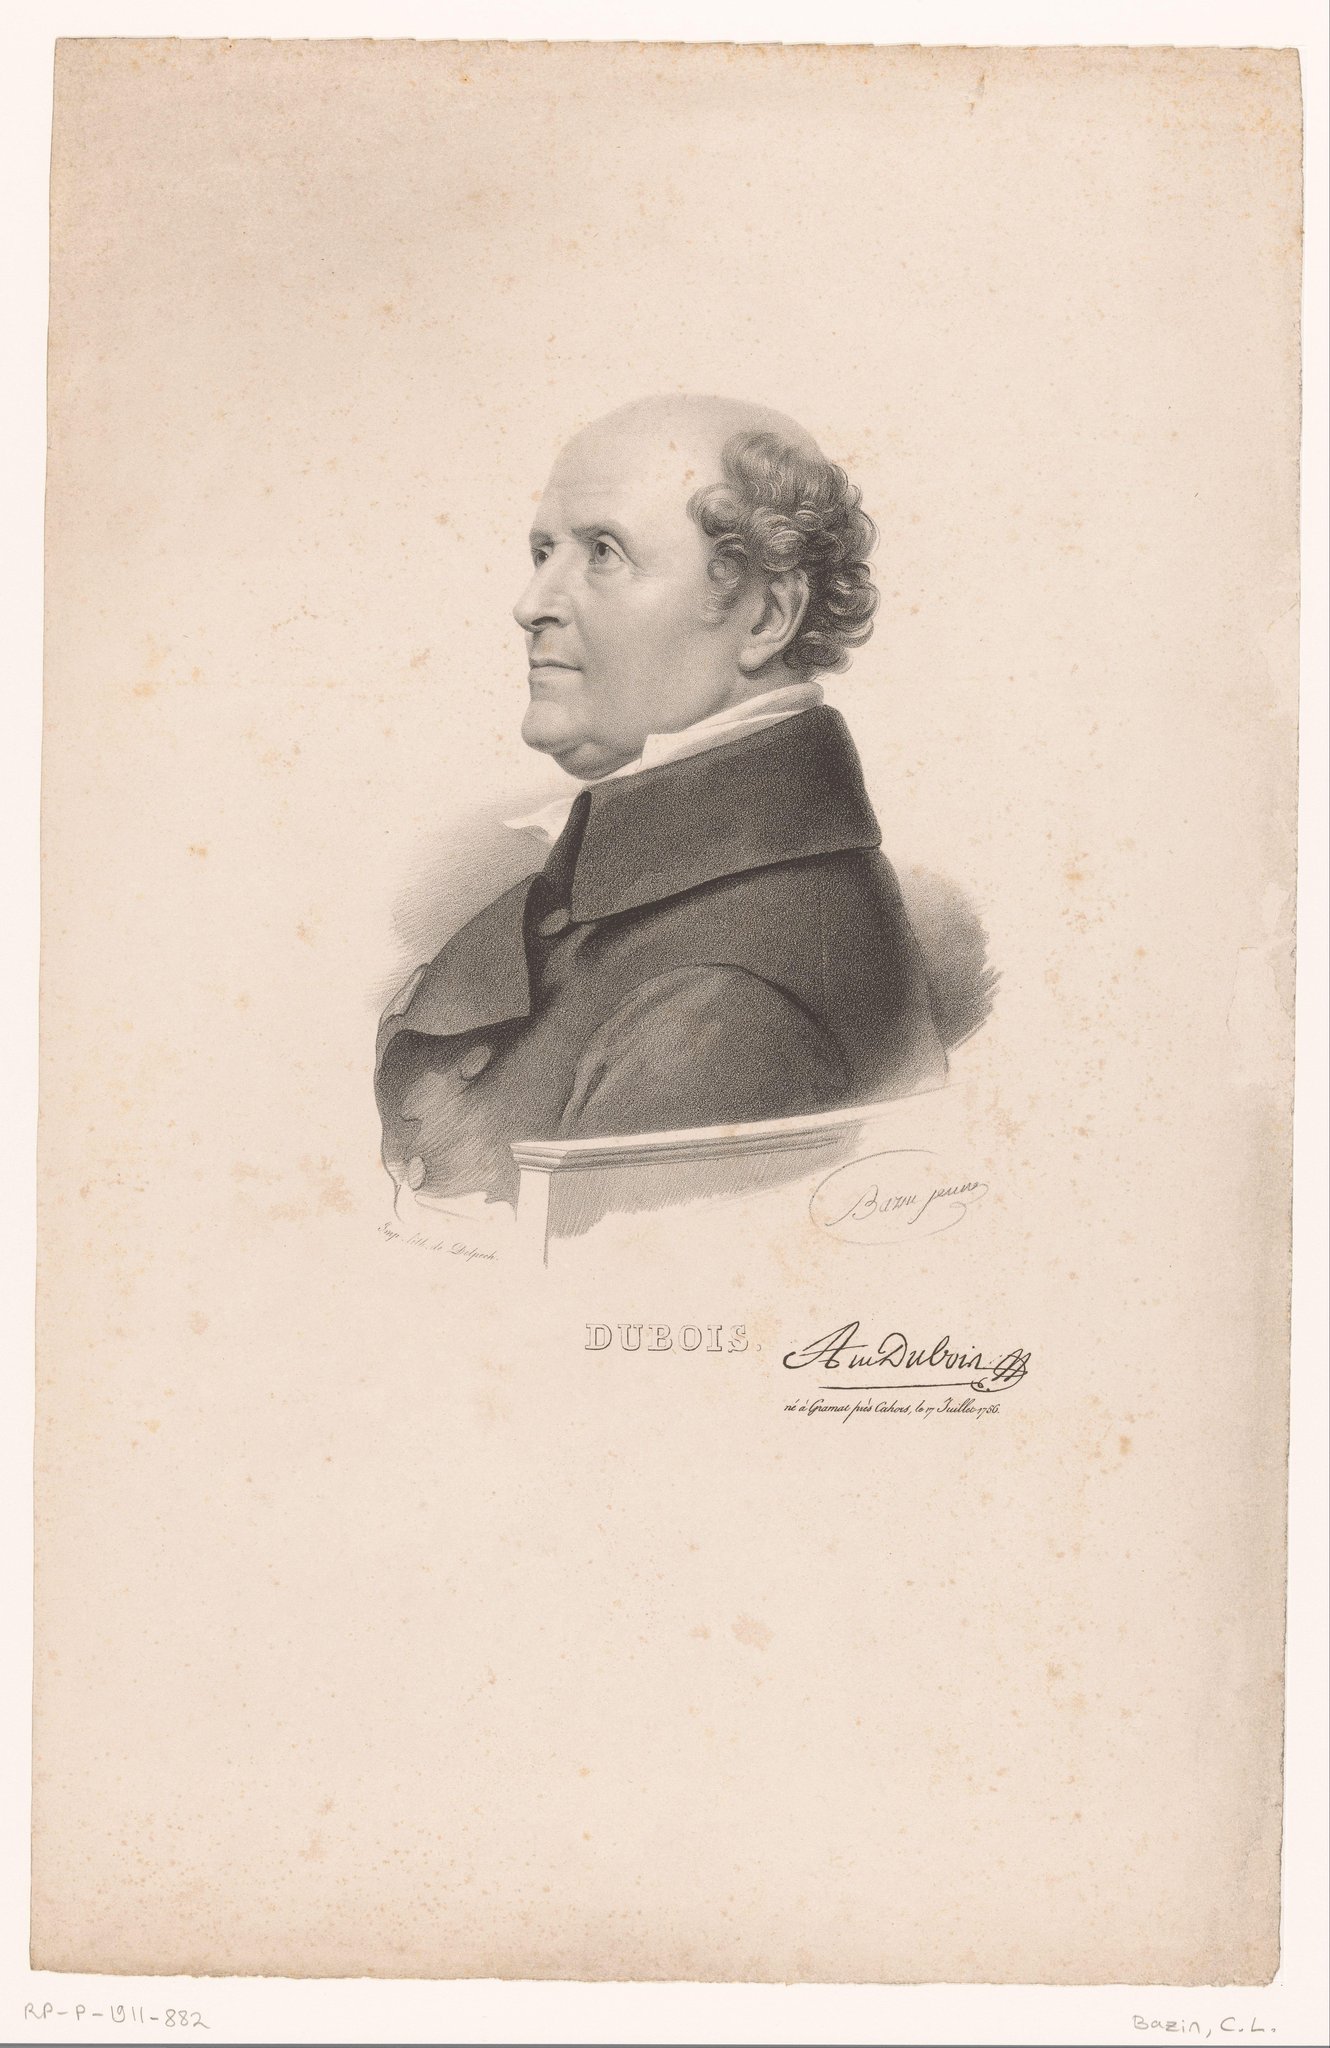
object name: print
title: Dubois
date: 1832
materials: paper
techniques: lithograph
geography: paris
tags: paris, historical persons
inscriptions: collector's mark: Lugt 2228a